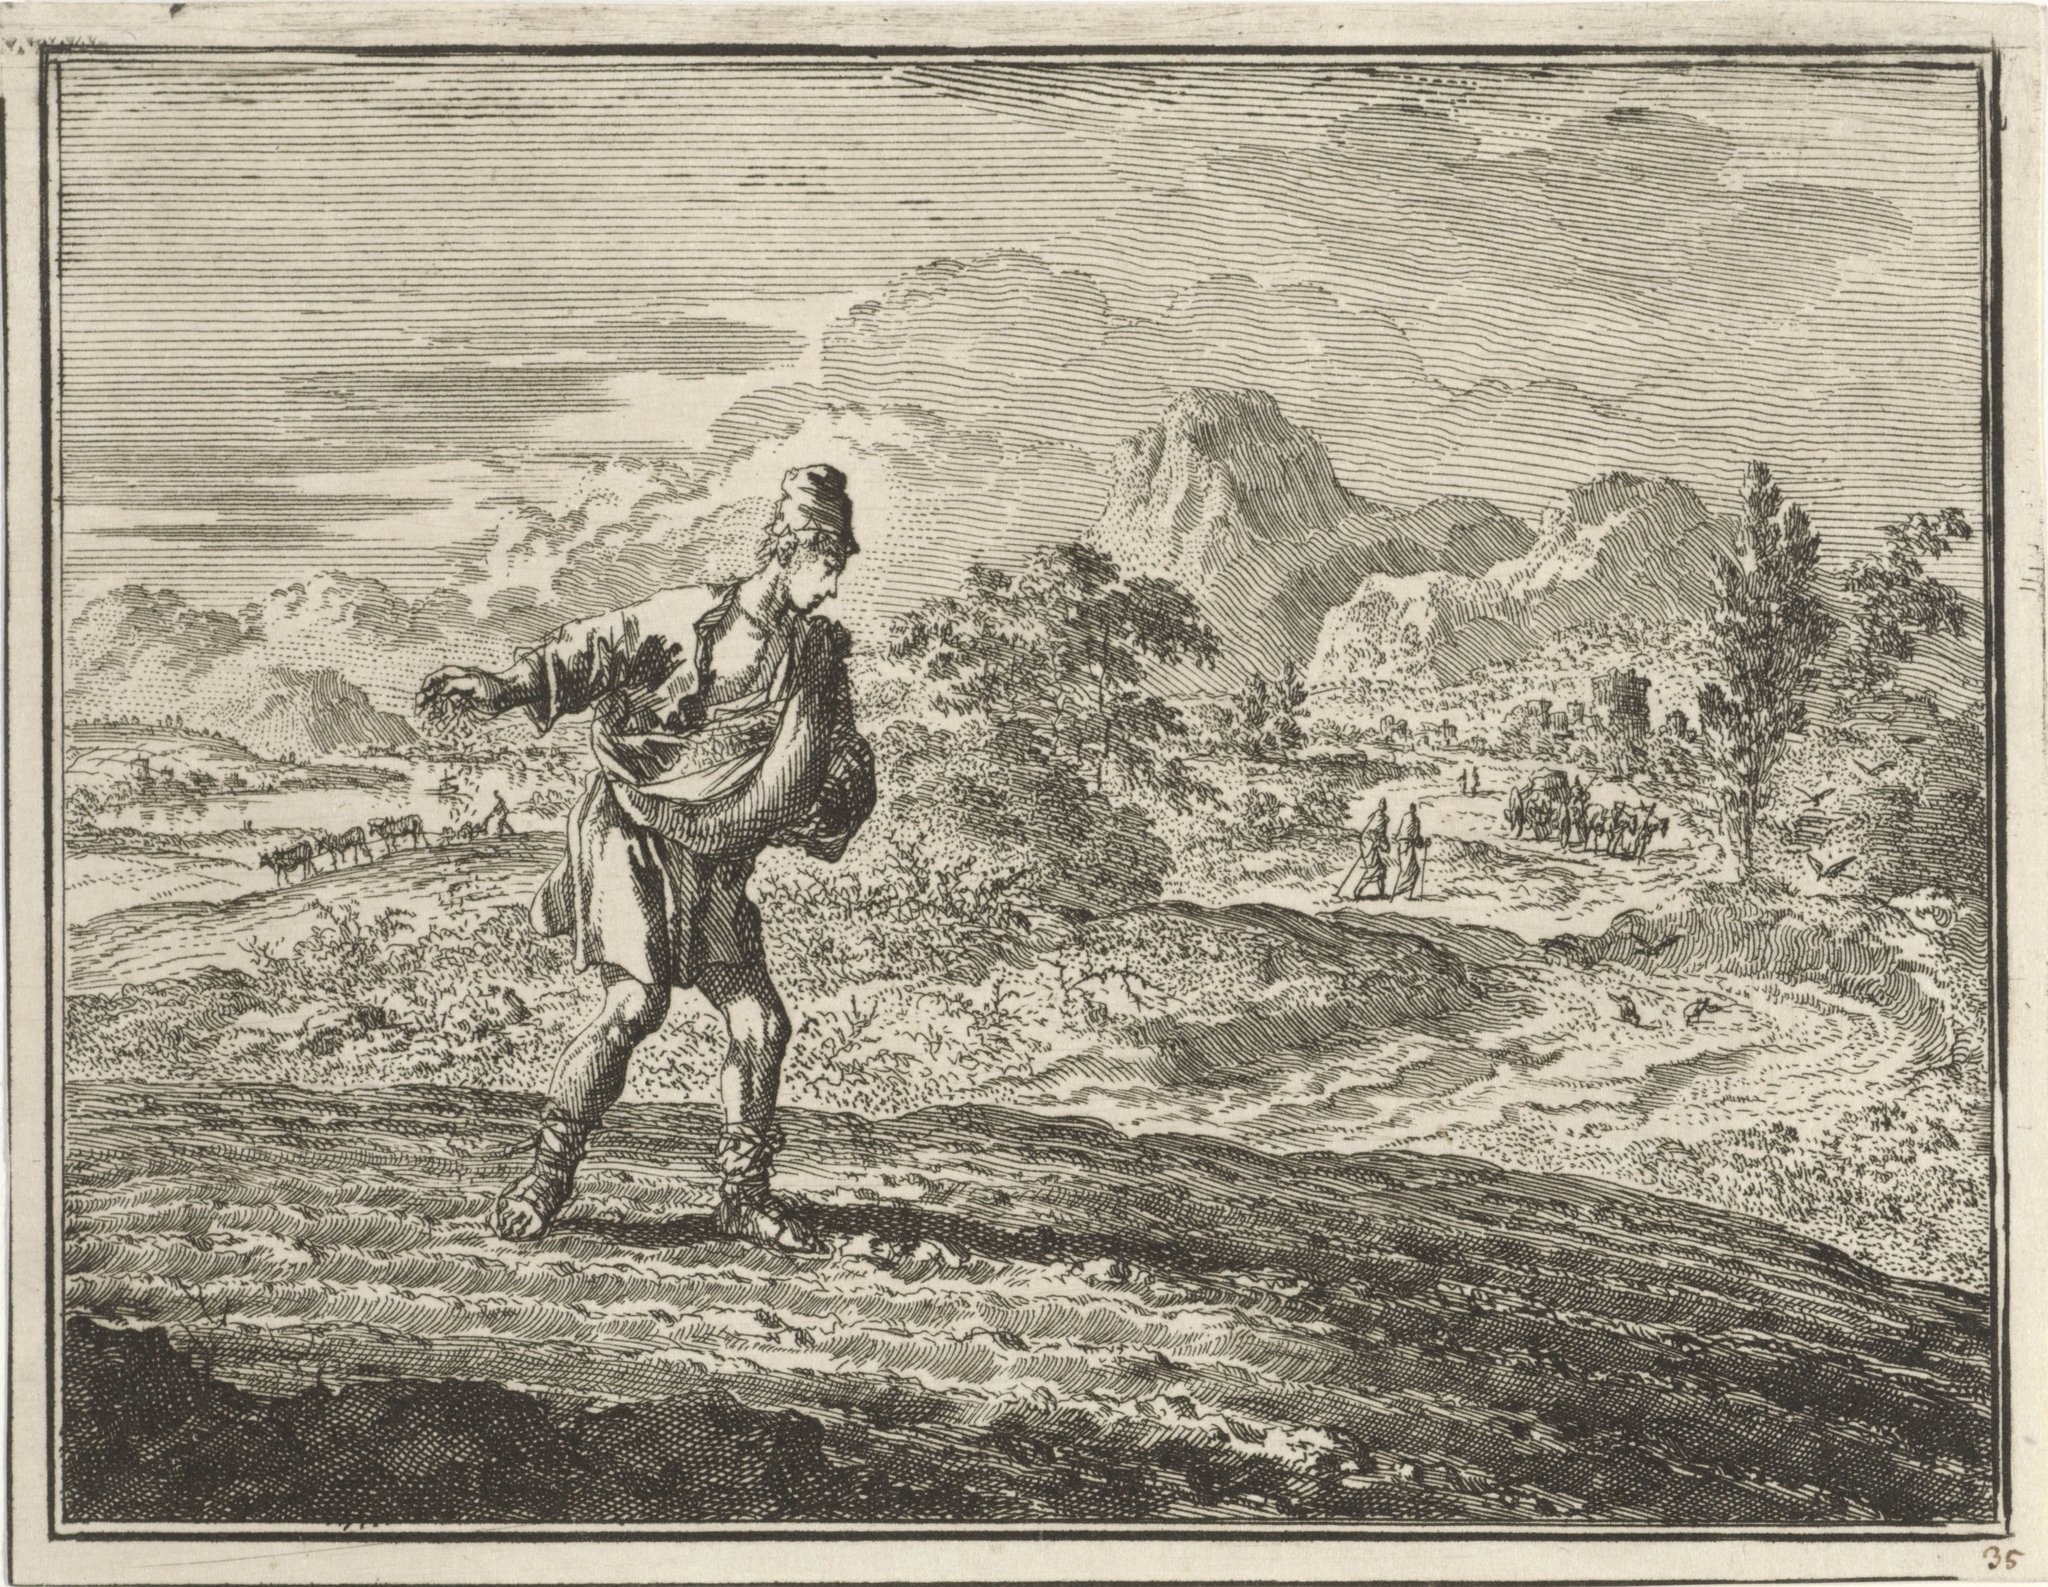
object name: print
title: Gelijkenis van de zaaier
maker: jan luyken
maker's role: draughtsman, print maker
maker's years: 1649-1712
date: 1712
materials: paper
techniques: etching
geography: amsterdam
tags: the sower ~ parable of christ (matthew 13:3-9; mark 4:3-9; luke 8:5-8)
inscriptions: collector's mark: Lugt 2228, number: ‘35’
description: Proefdruk van illustratie uit: Luyken, Jan. De schriftuurlyke geschiedenissen en gelykenissen van het Oude en Nieuwe Verbond, 2 delen. Amsterdam: Wed. Pieter Arentsz II en Cornelis van der Sys, 1712, dl. II.